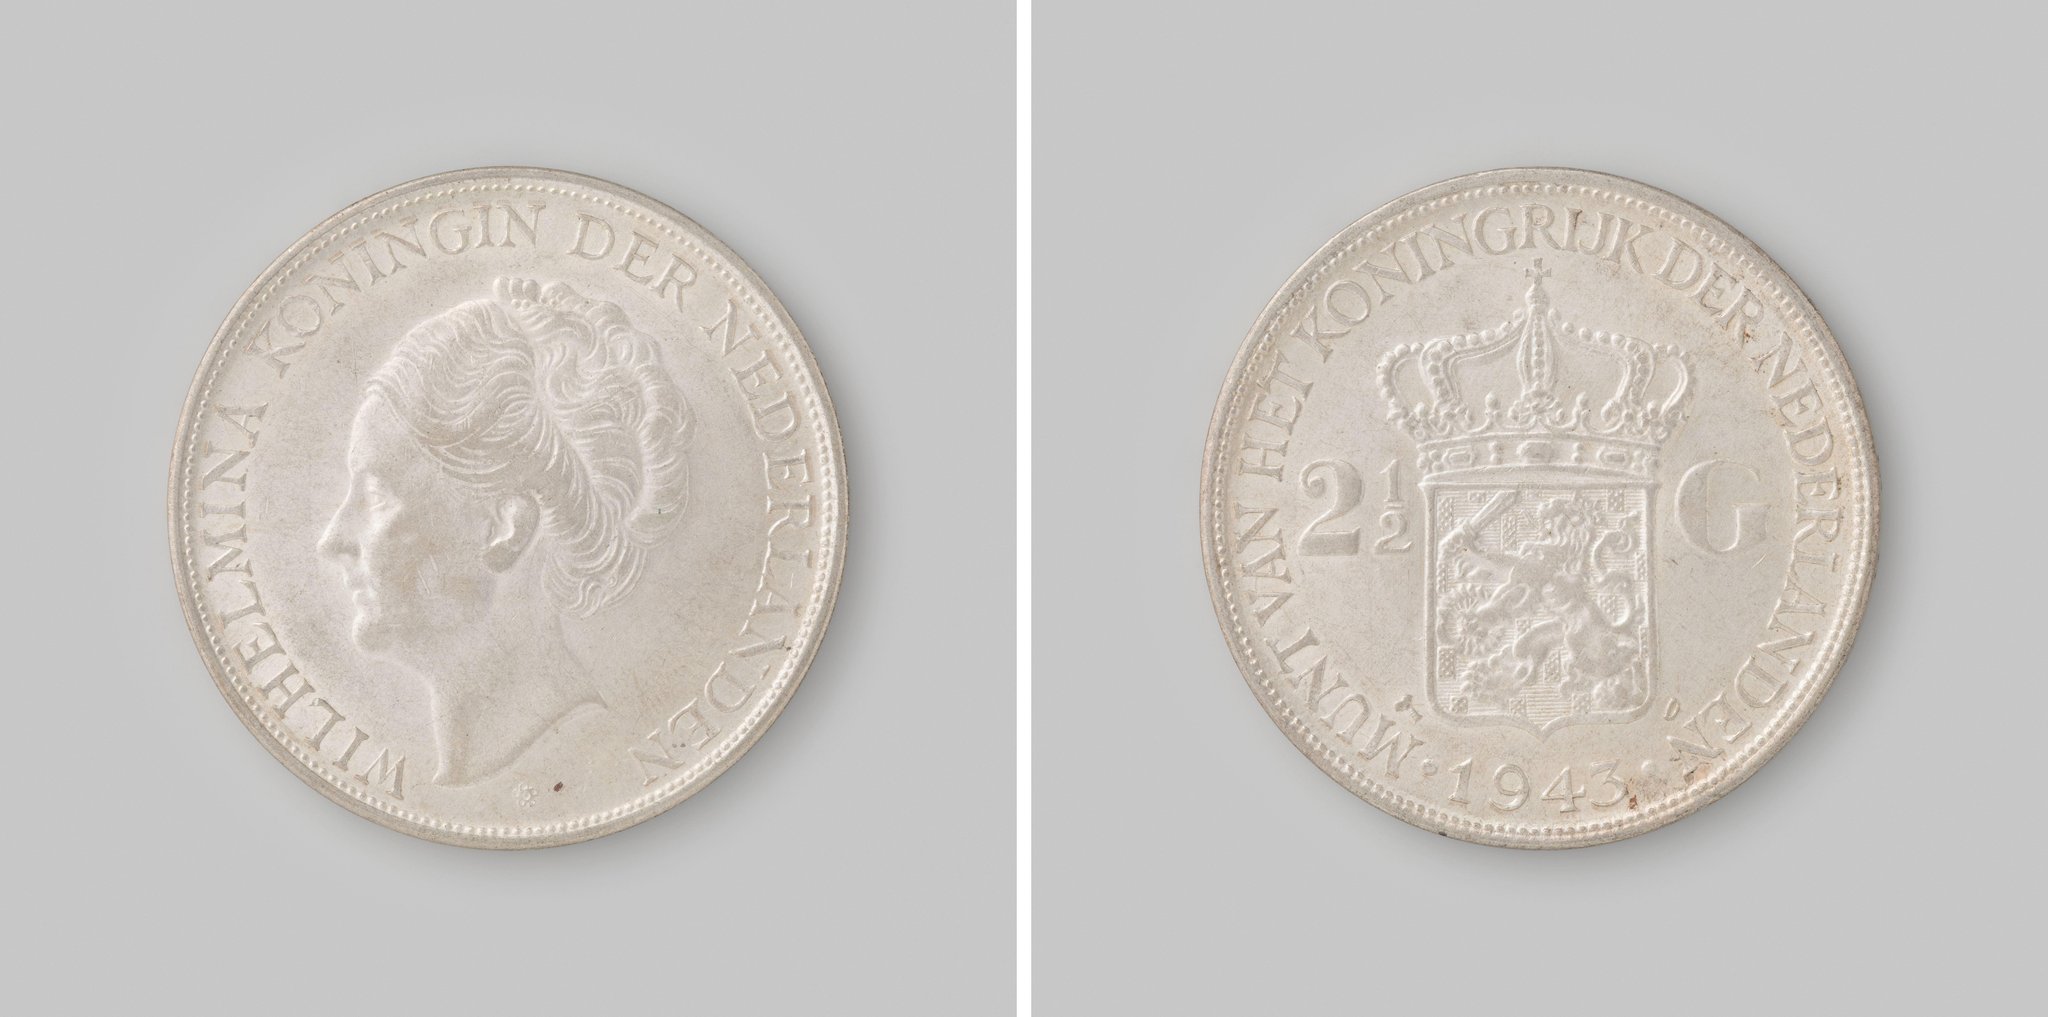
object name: coin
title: Nederland, 2½ gulden voor Nederlands-Indië, 1943 D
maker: wilhelmina of the netherlands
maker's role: print maker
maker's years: 1880-1962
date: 1943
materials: silver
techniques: striking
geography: denver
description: Zilveren munt. Voorzijde: hoofd naar links. Keerzijde: tussen waarde-aanduiding 2½ G gekroond rijkswapenschild. Linksonder wapenschild palmboom en rechtsonder letter D [=Denver]. Jaartal onderaan in omschrift. Randschrift.